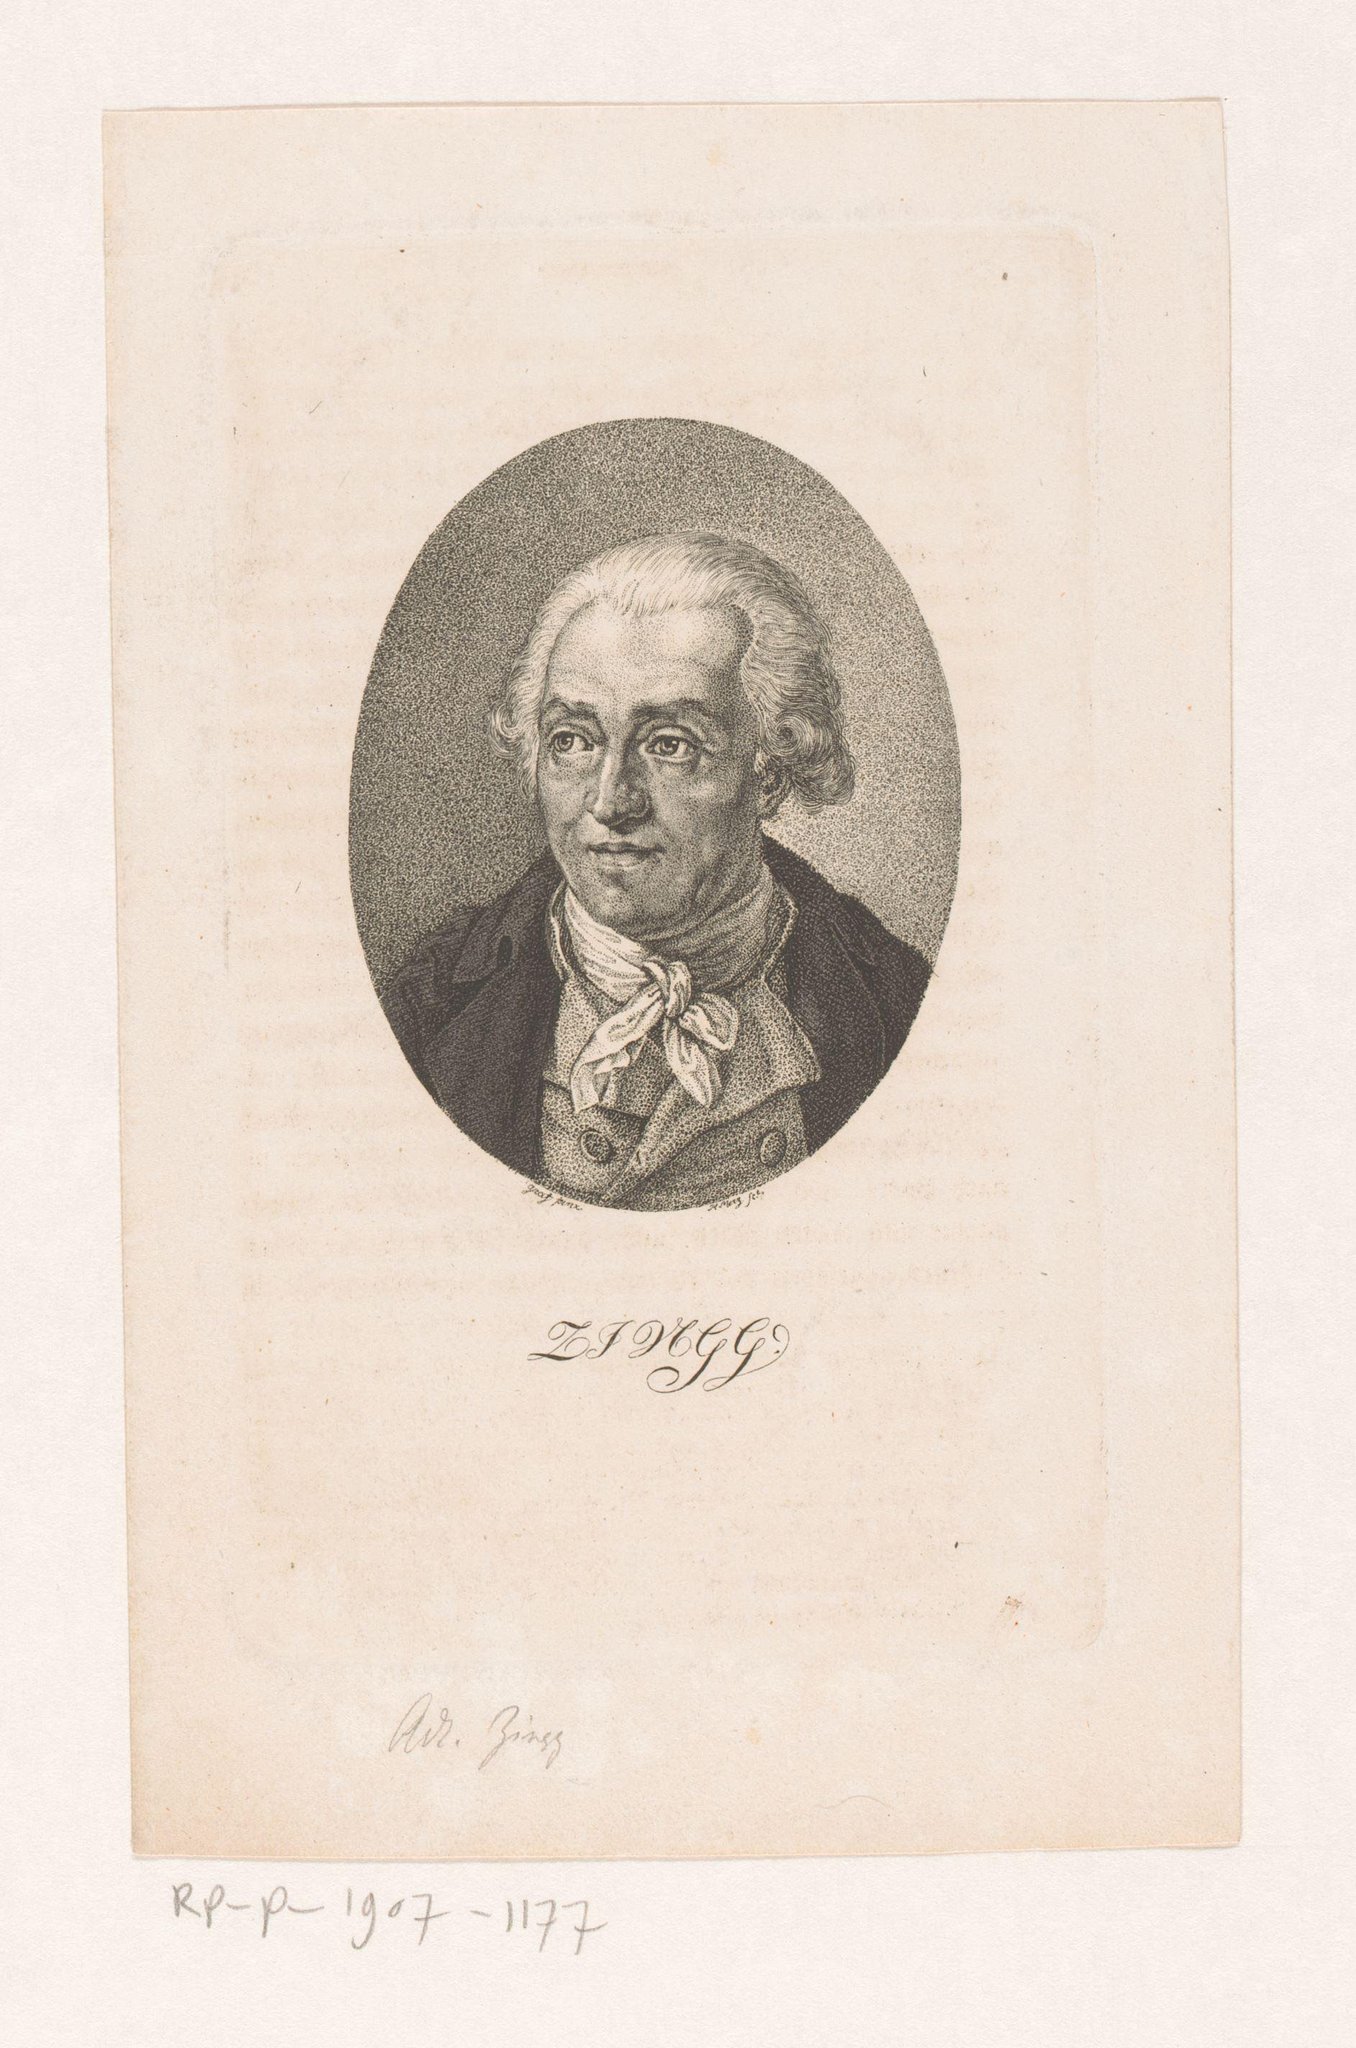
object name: print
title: Portret van Adrian Zingg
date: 1816-1875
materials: paper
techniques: stippled etching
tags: print maker, draughtsman, adrian zingg, historical persons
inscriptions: collector's mark: Lugt 2228